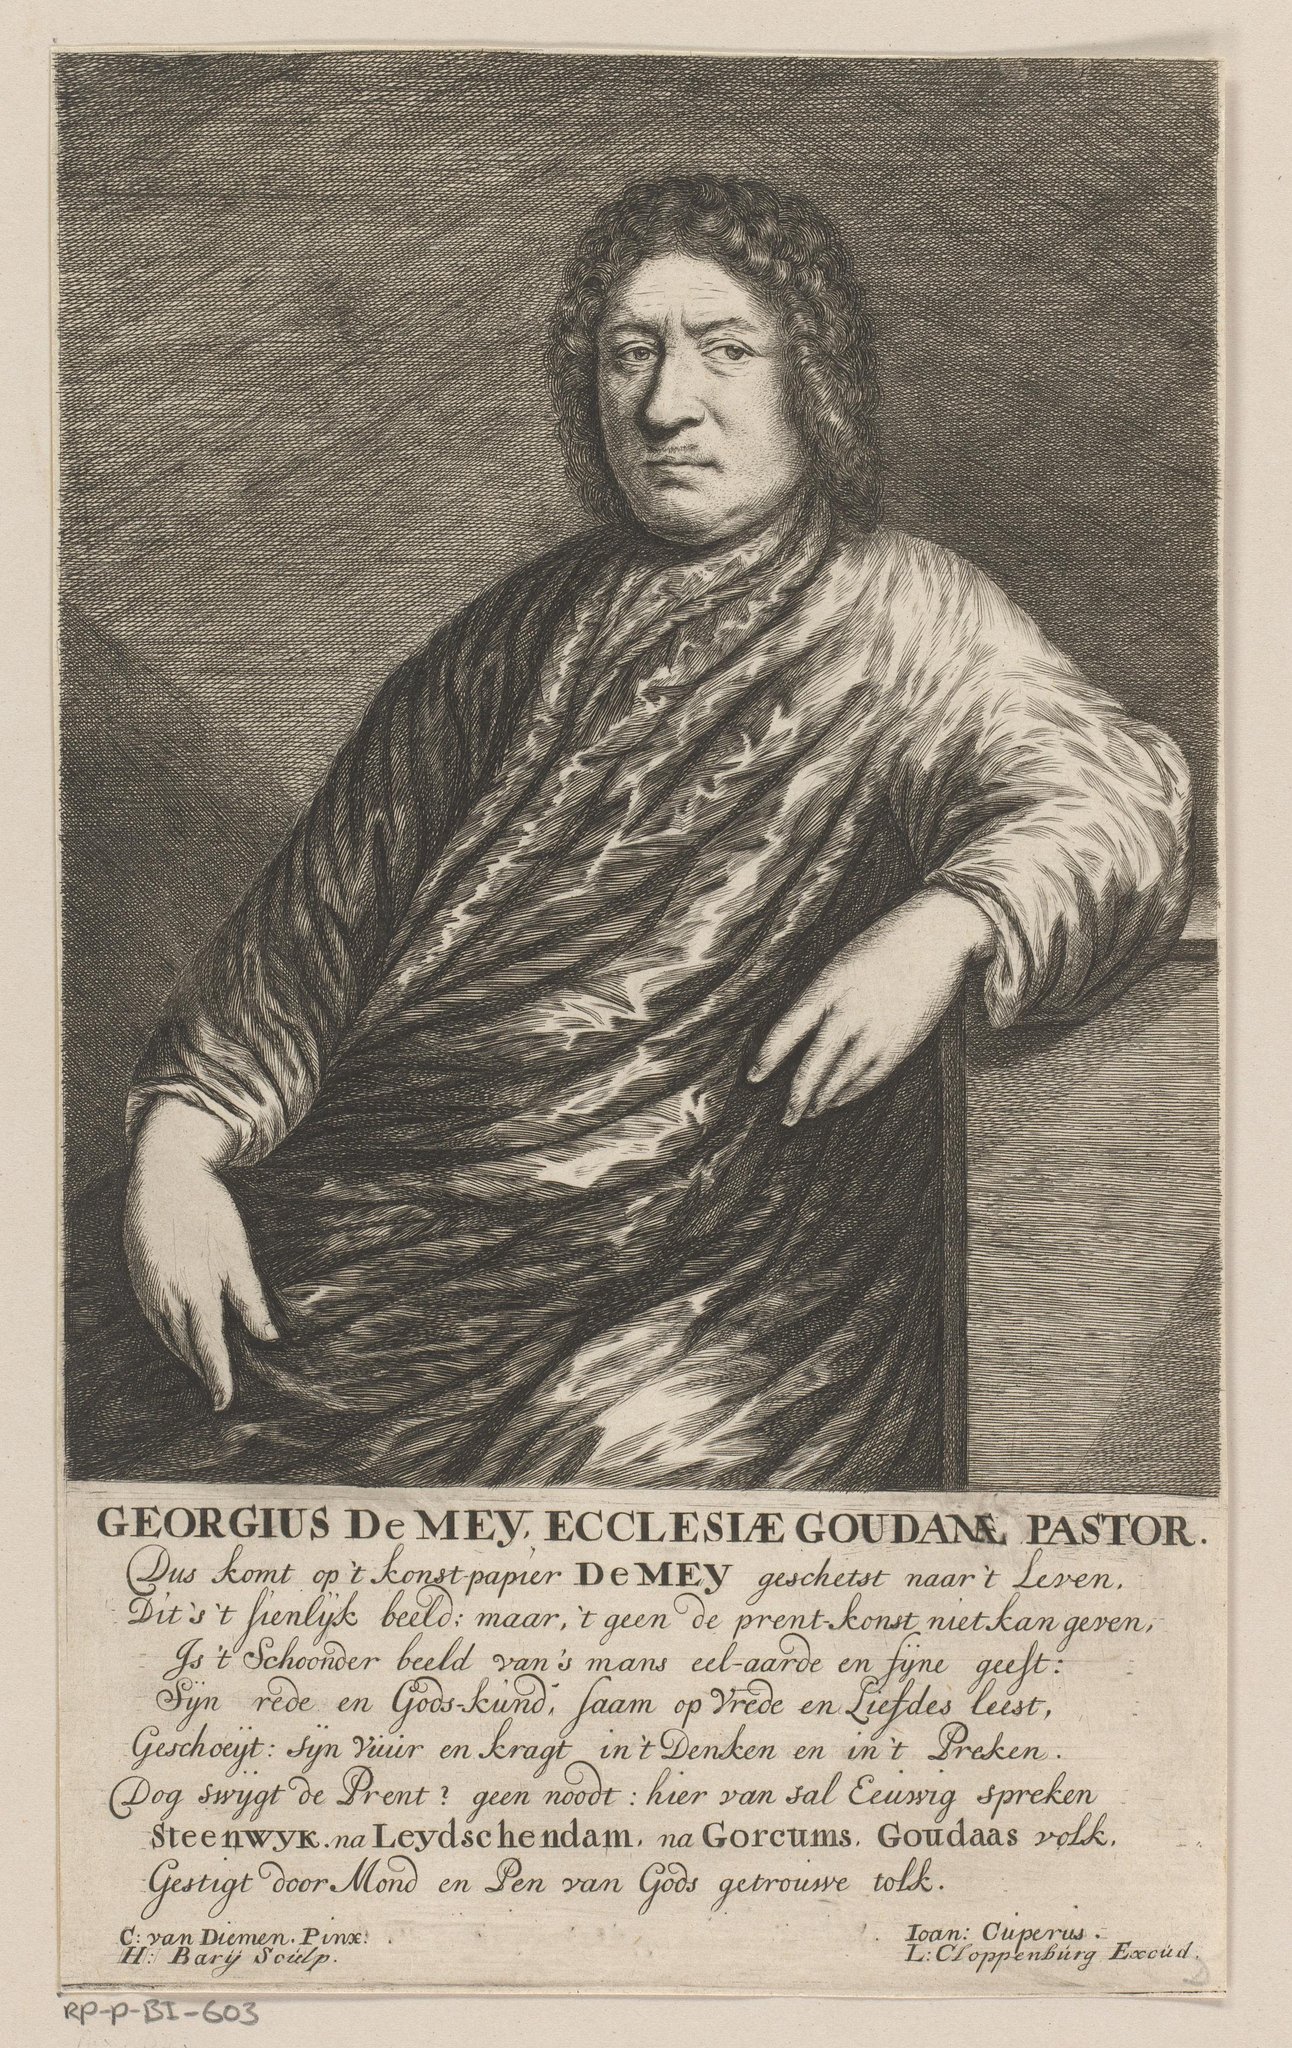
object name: print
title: Portret van Georgius de Mey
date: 1695-1707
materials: paper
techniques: engraving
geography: gouda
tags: historical persons, functionaries and dignitaries ~ protestant churches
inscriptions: collector's mark: Lugt 240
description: Met een achtregelig Nederlands vers als onderschrift.